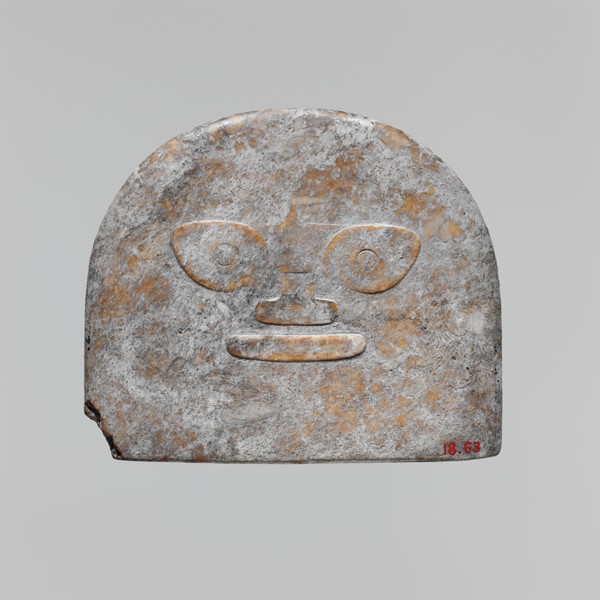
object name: ornament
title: Ornament with Mask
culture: chinese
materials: jade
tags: masks